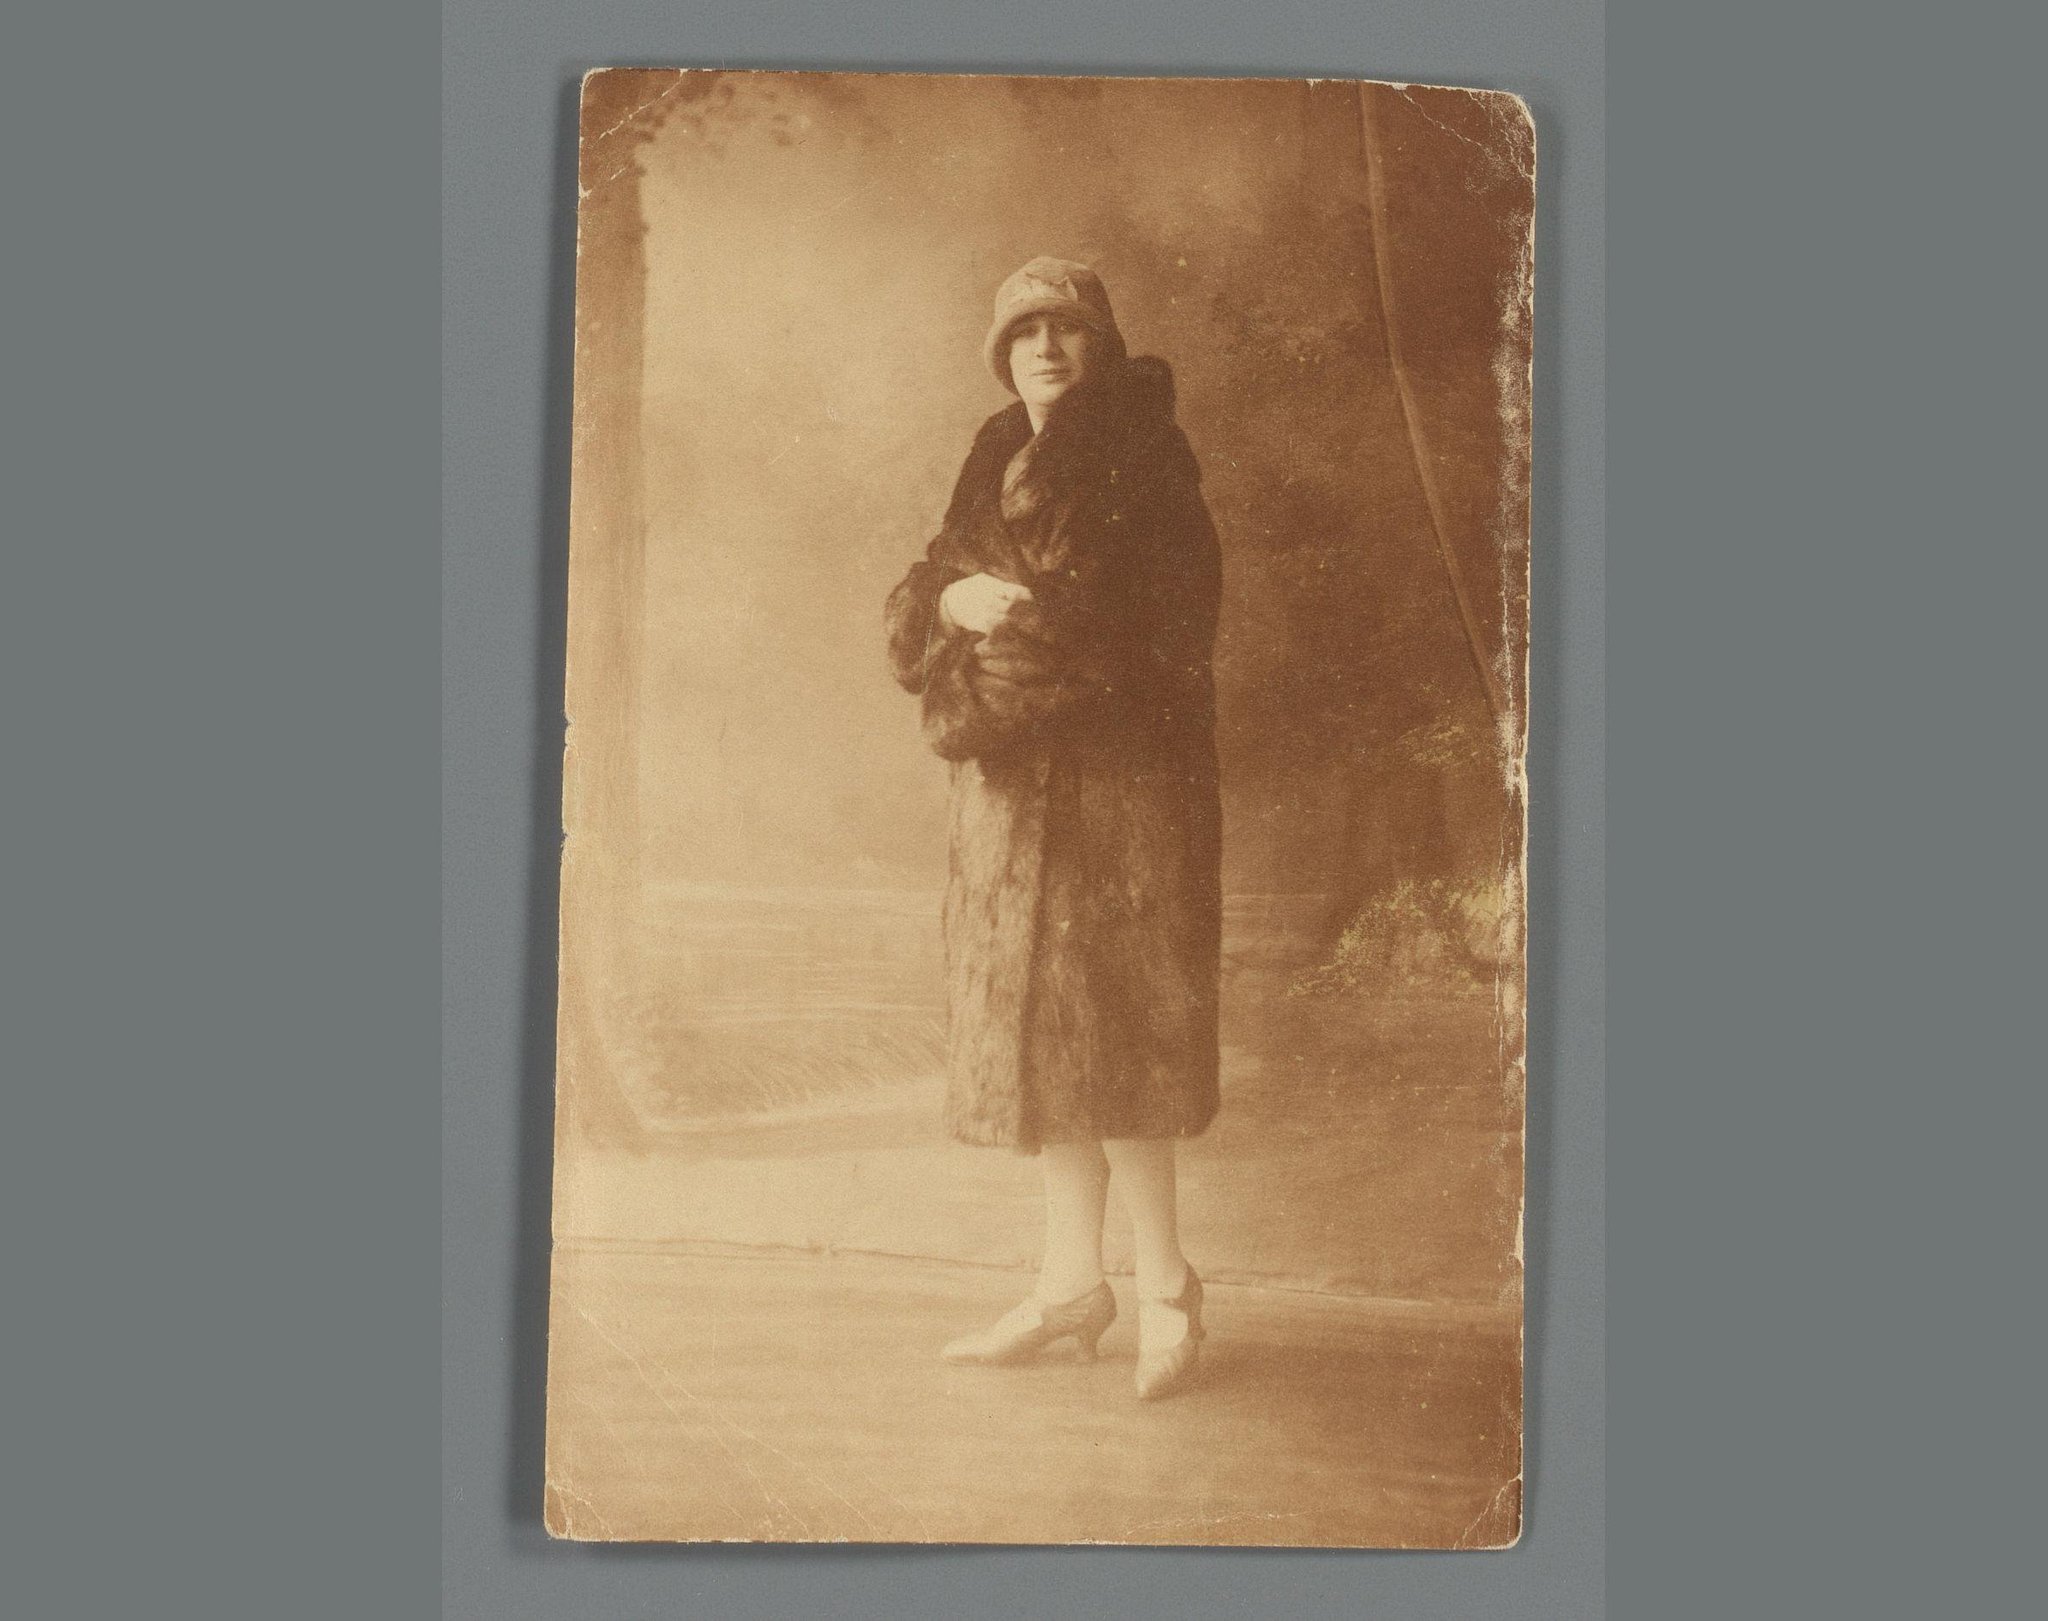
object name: photograph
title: Portret van Cato Merks in een fotostudio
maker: Anonymous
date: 1910-1930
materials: paper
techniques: gelatin silver print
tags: historical persons - bb - woman, portrait of cabaret-artiste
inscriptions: inscription: ‘Cato Merks’